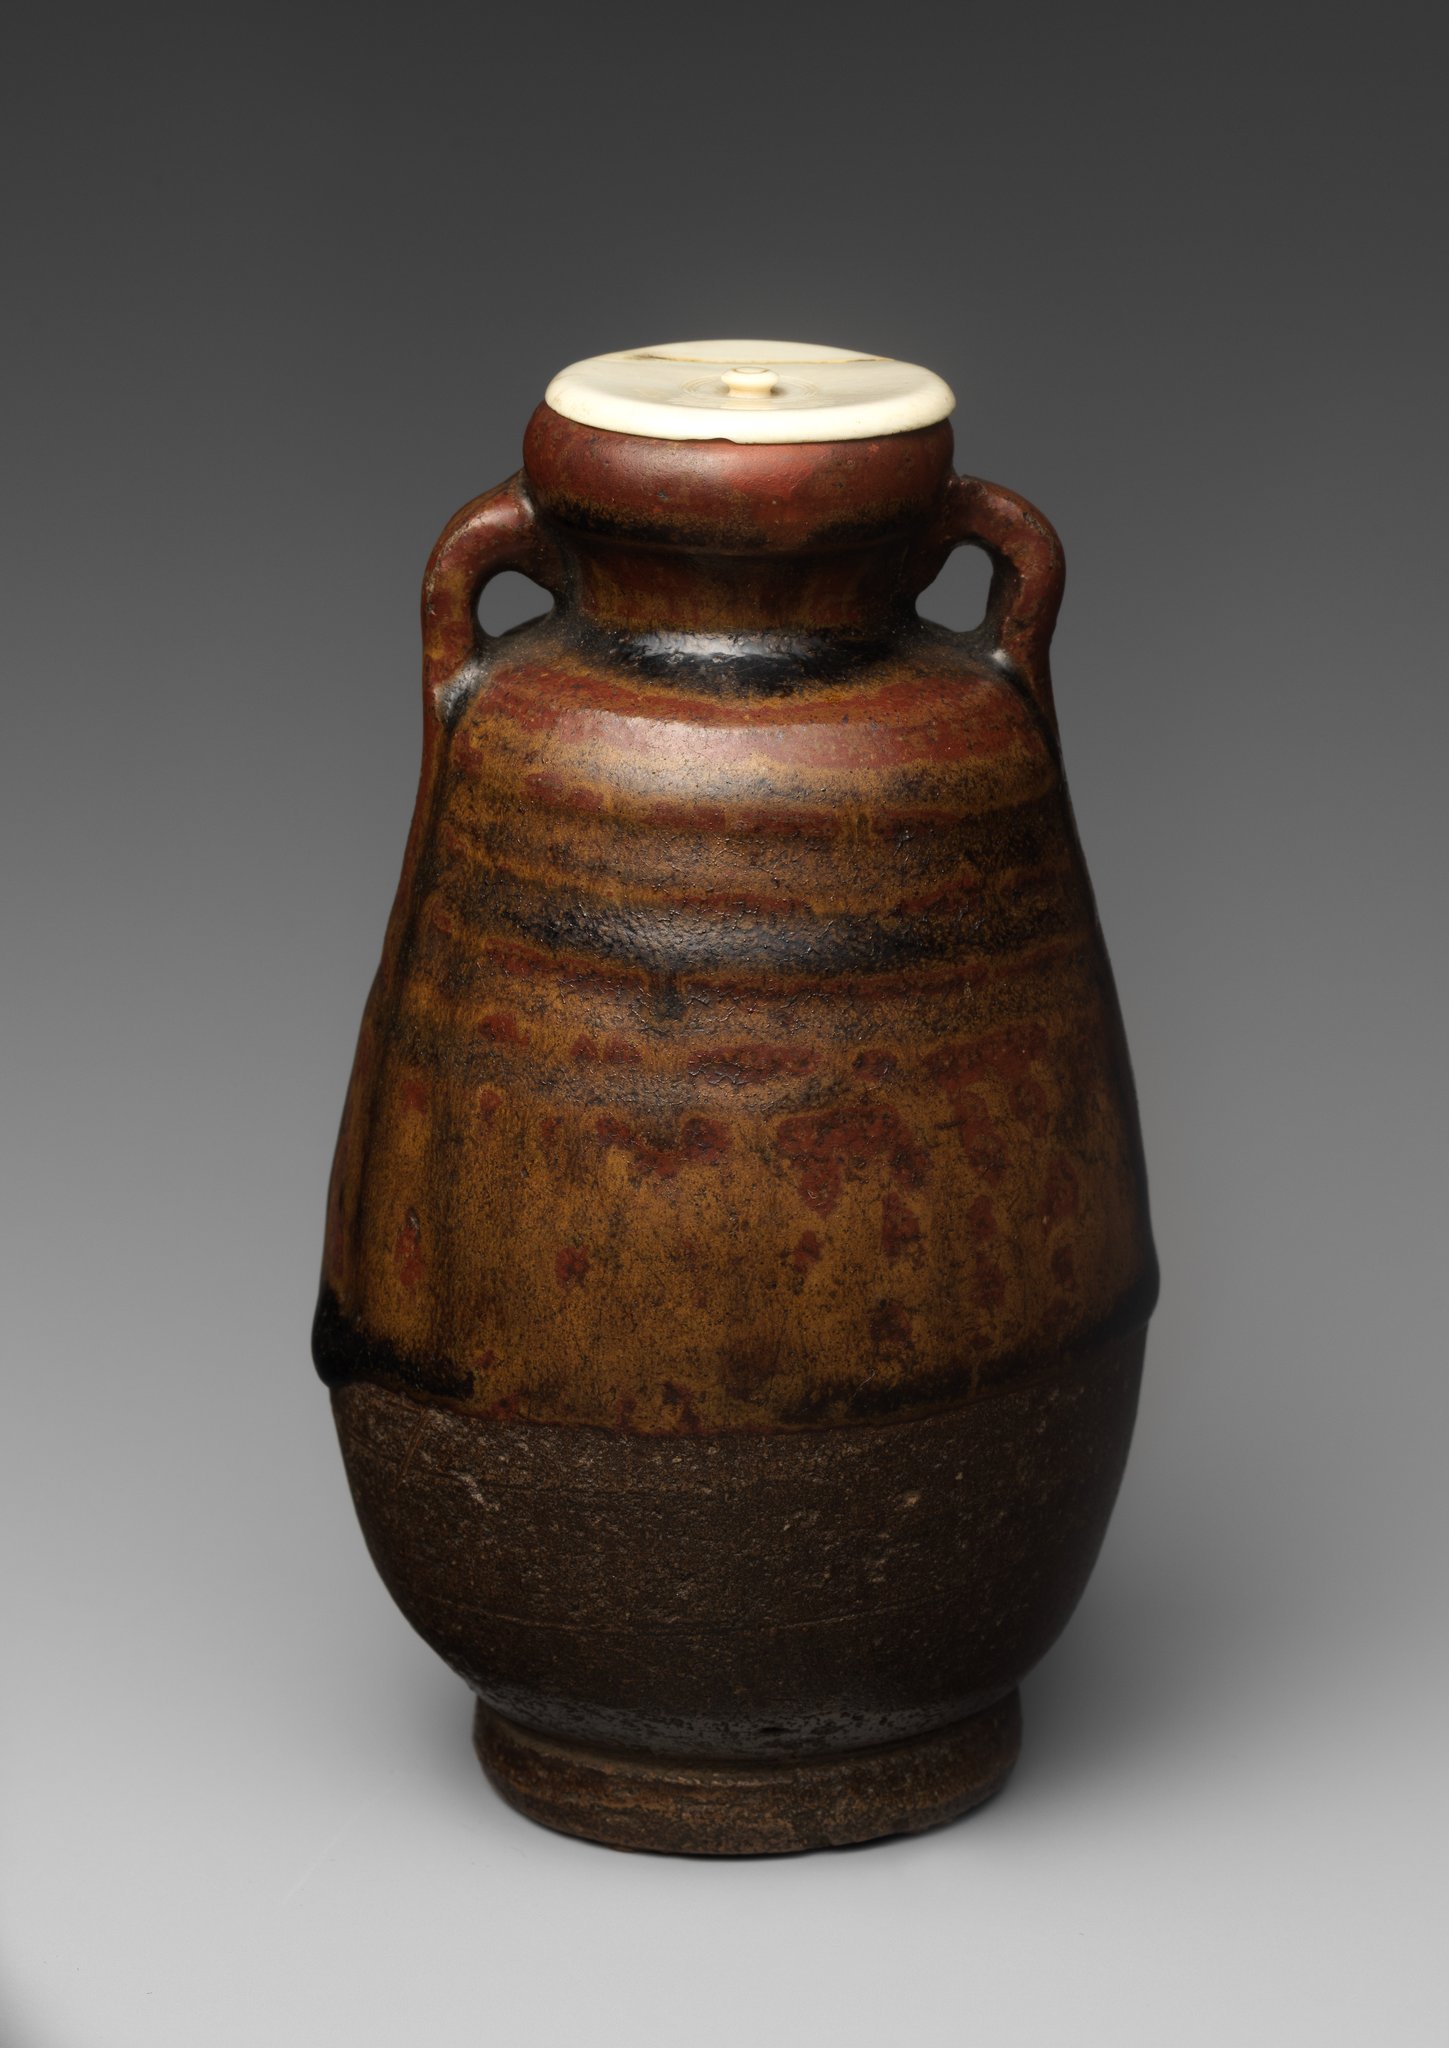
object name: tea jar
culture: japanese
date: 1601-1700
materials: clay, glaze